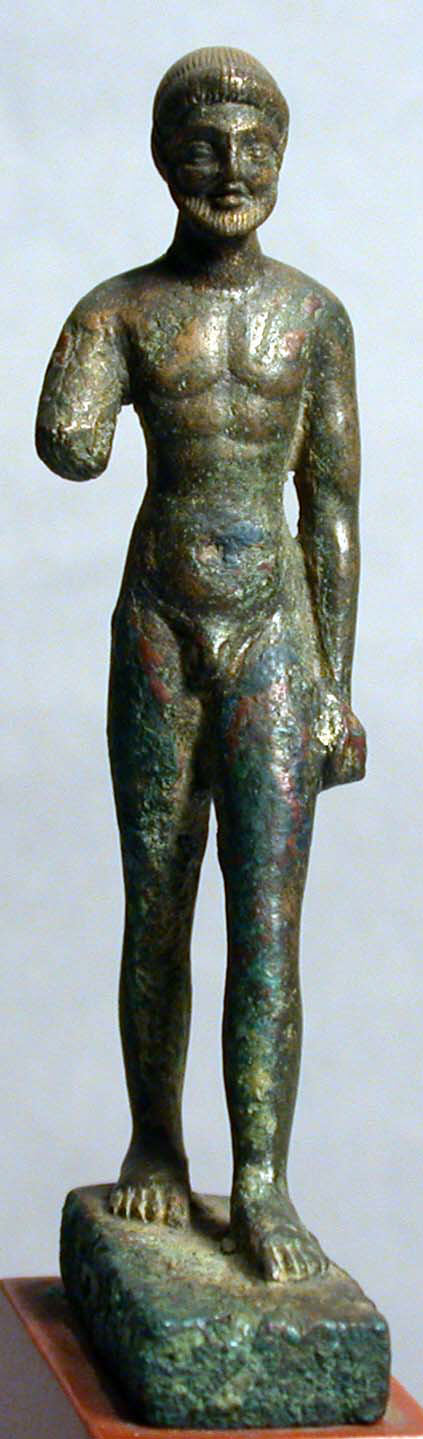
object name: statuette of a bearded man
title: Bronze statuette of a bearded man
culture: greek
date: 534-501 BCE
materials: bronze